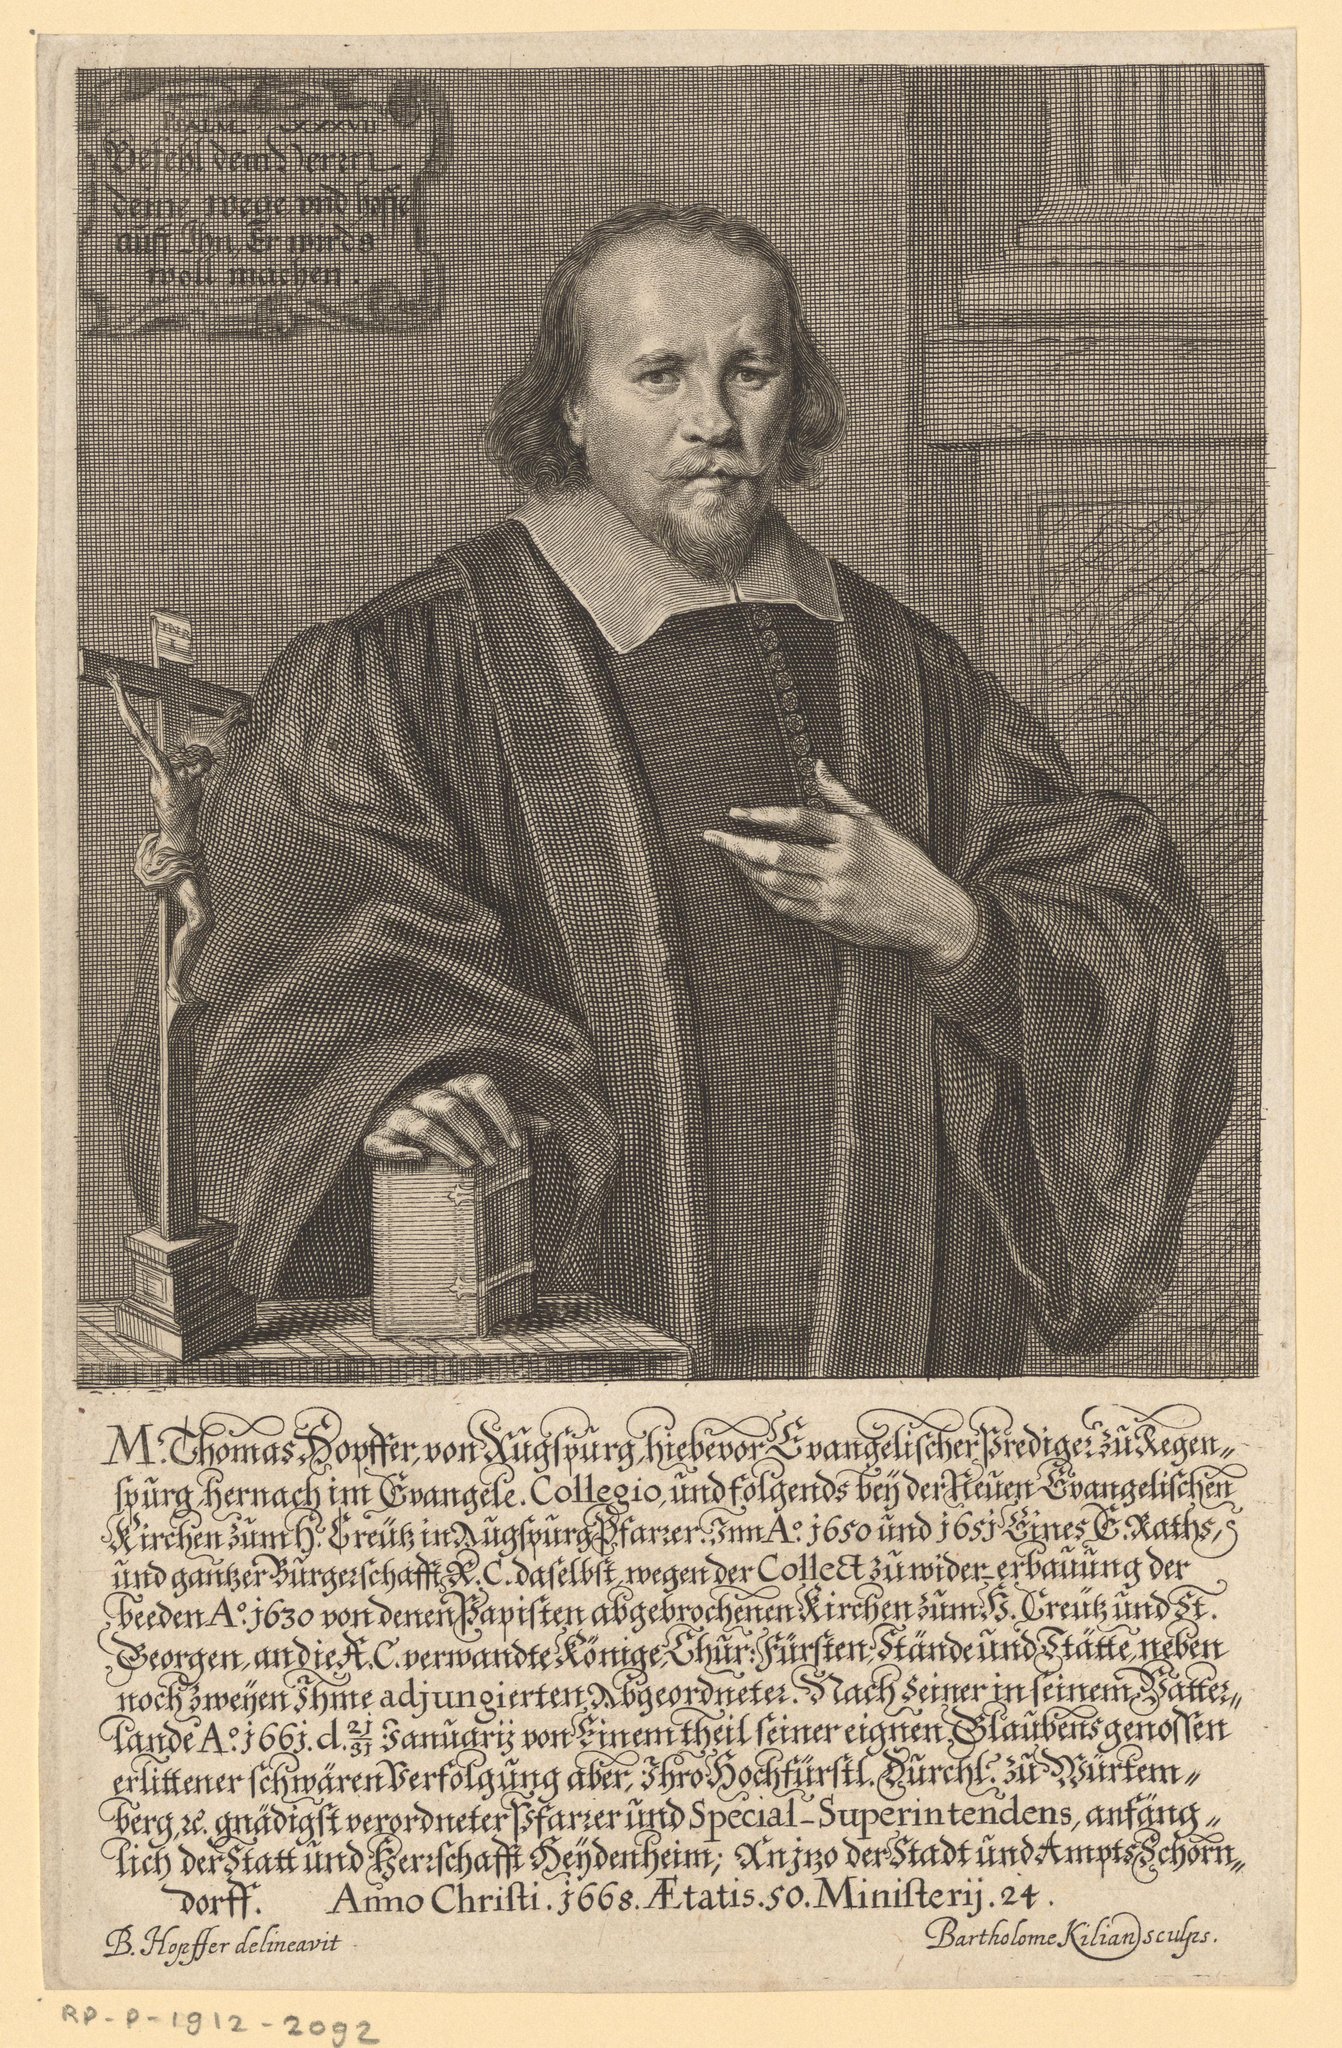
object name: print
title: Portret van Thomas Hopffer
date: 1668-1696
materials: paper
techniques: engraving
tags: augsburg, altarcross, crucifix, theologian, historical persons, book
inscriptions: collector's mark: Lugt 2228